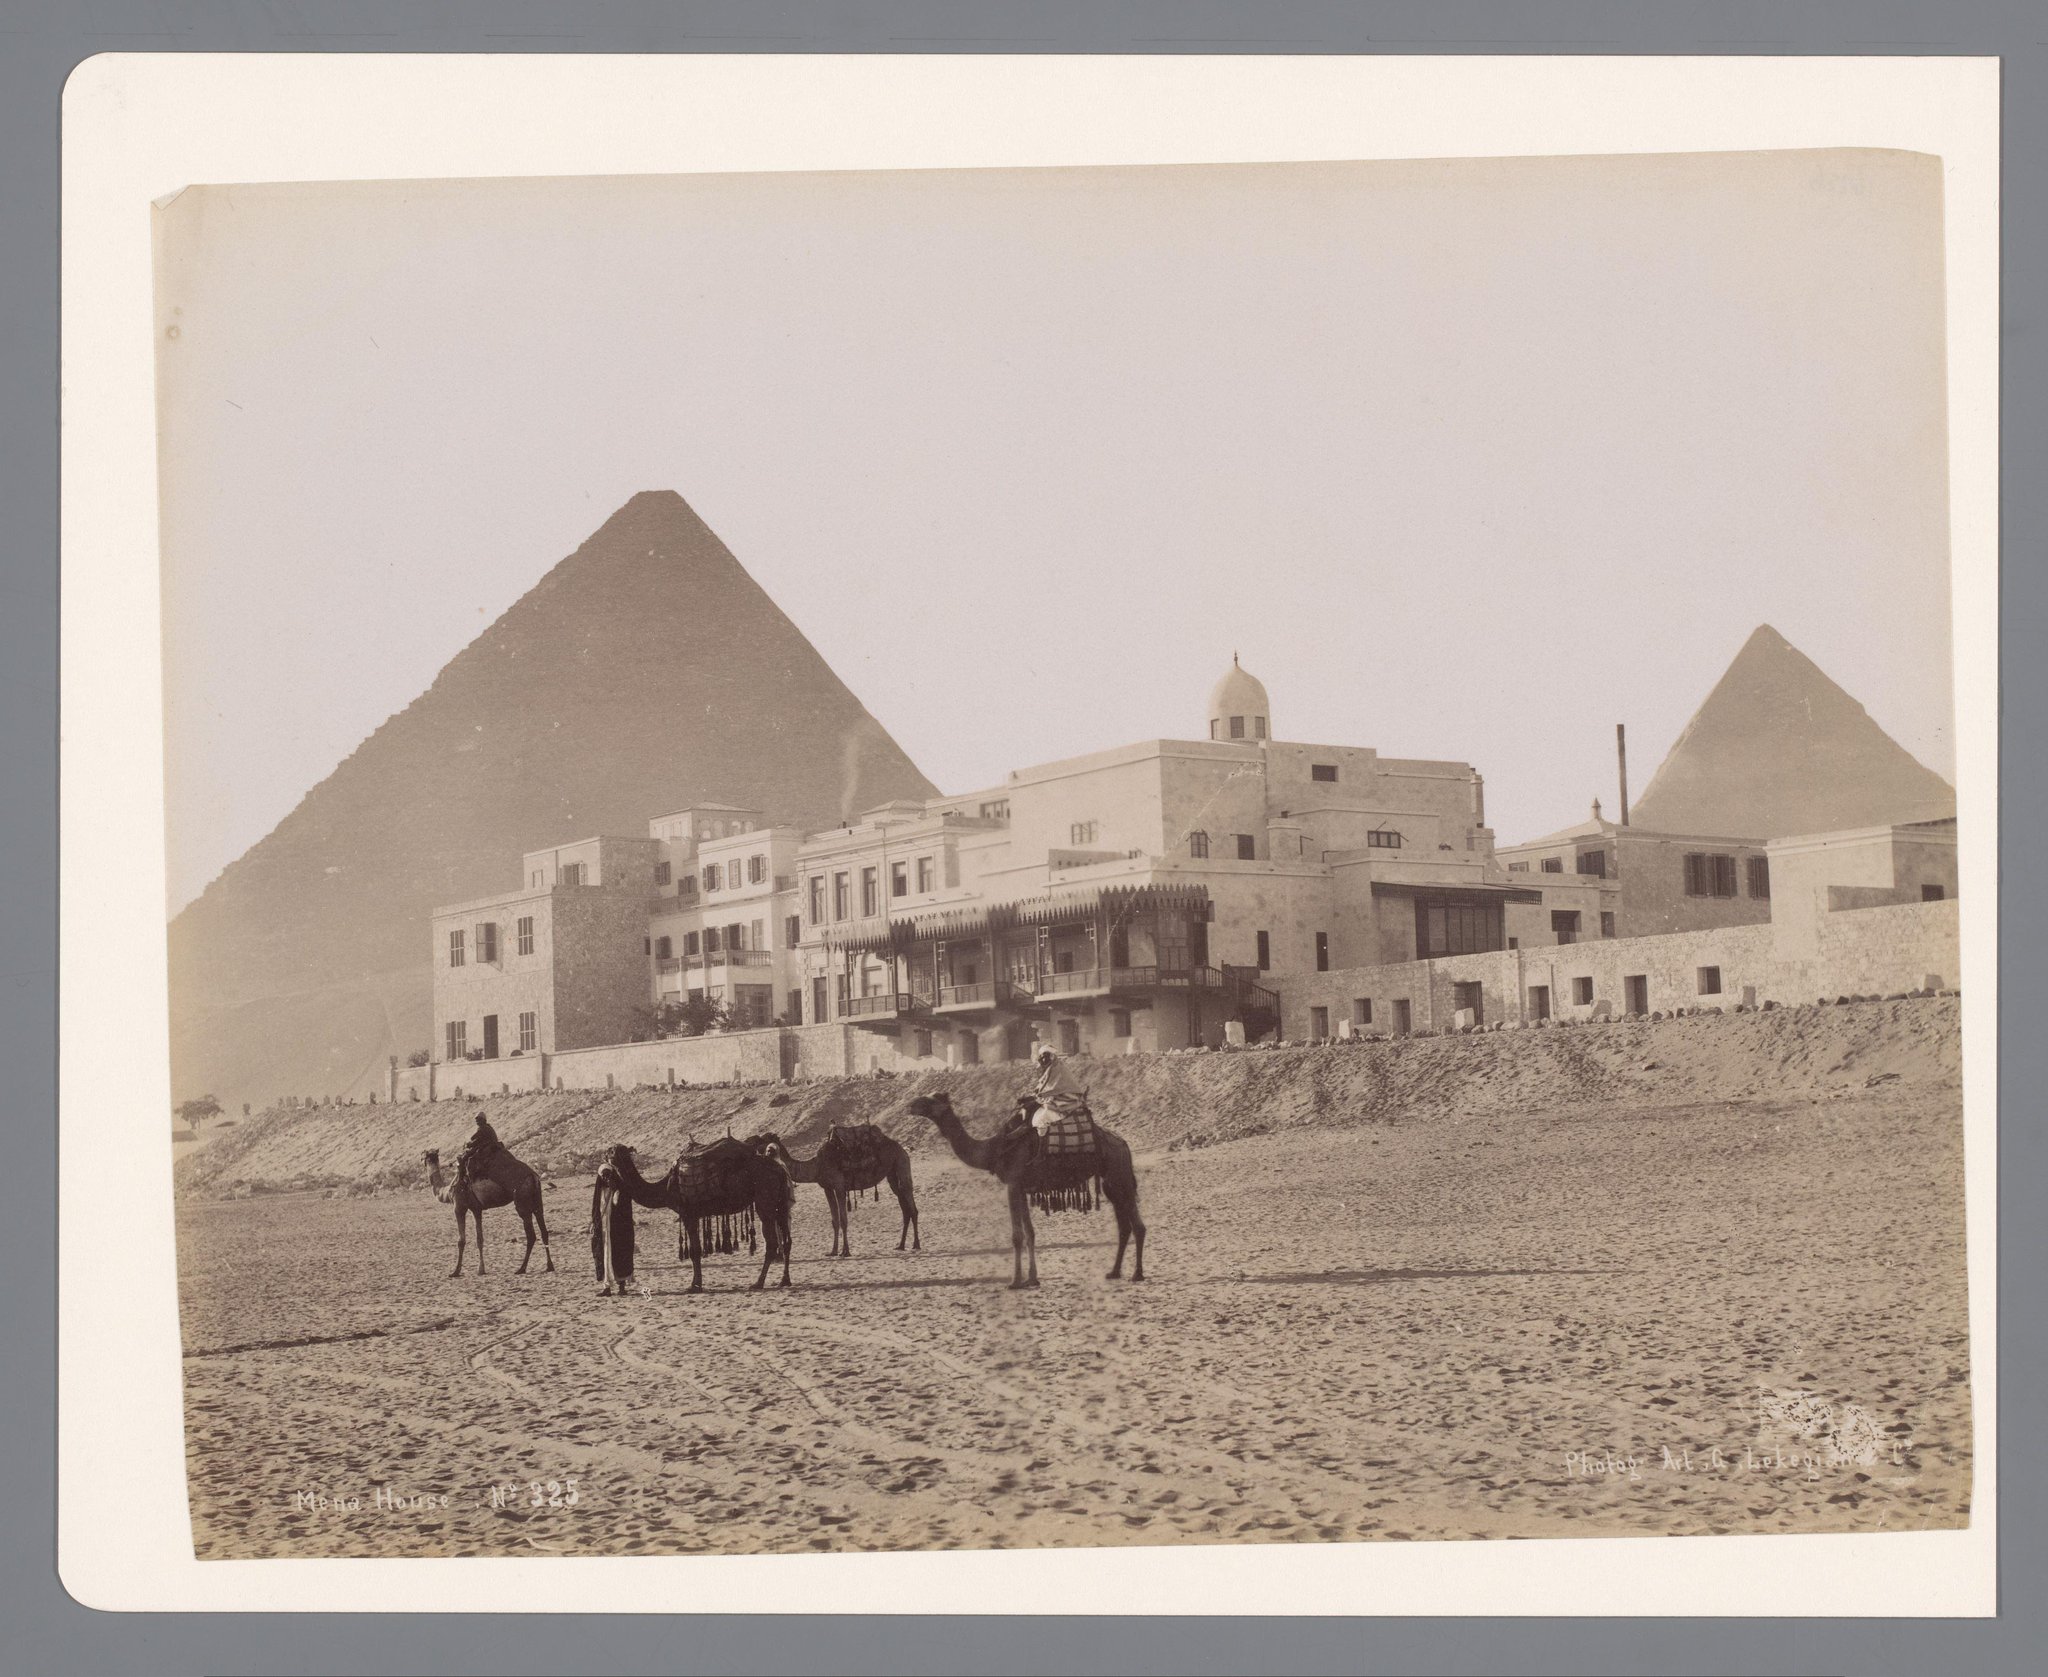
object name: photograph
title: Gezicht op het Mena House Hotel nabij Caïro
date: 1887-1900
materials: paper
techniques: albumen print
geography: cairo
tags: pyramid (historical grave form), hotel, hostelry, inn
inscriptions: number: ‘No 325’